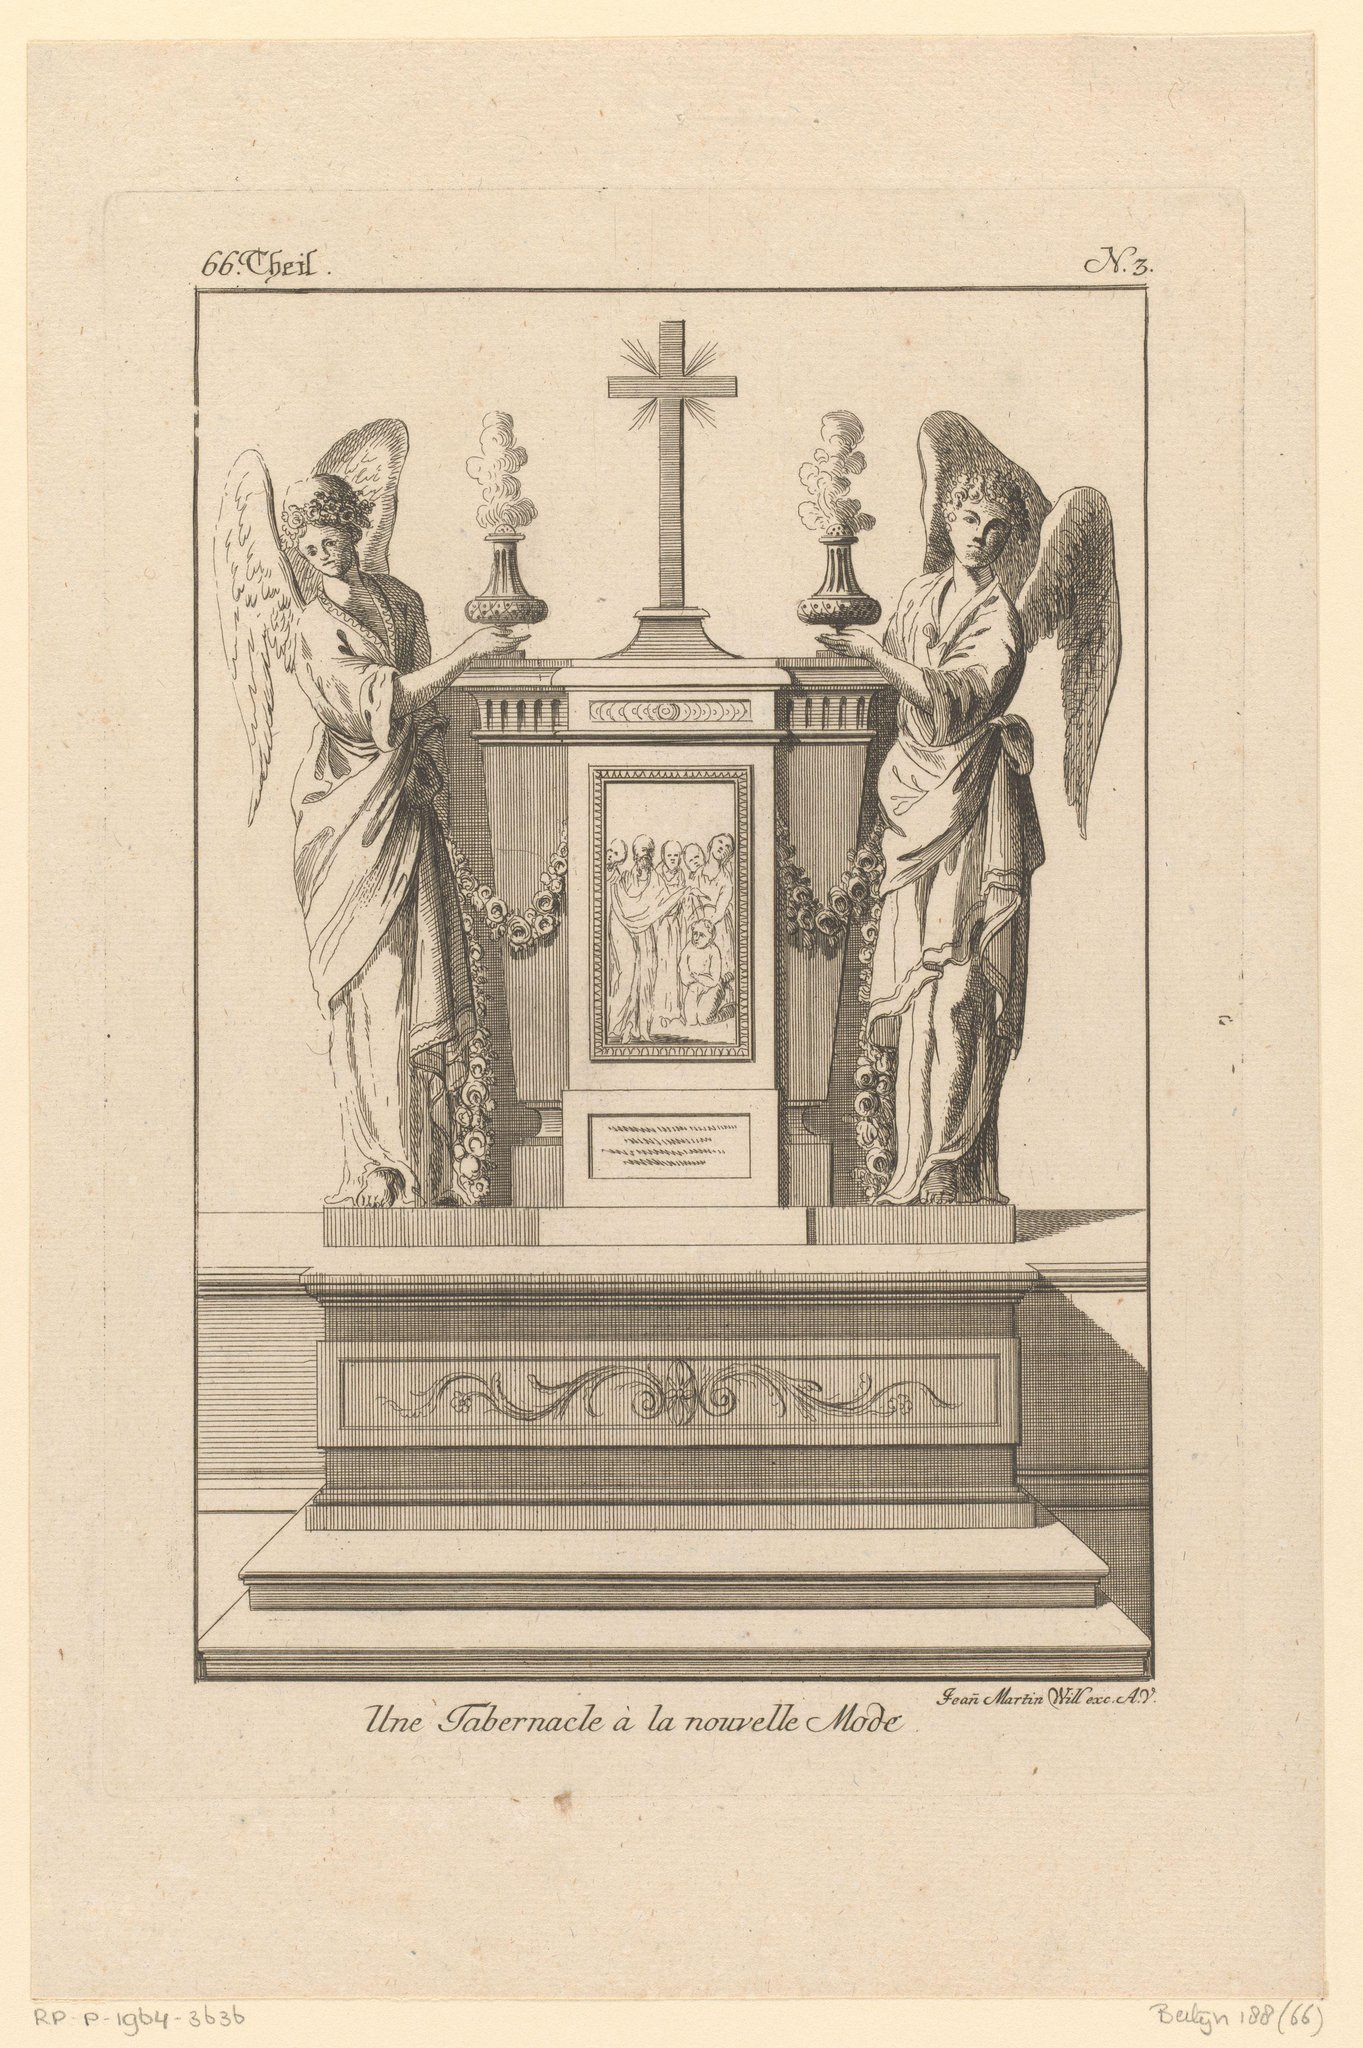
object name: print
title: 66. Theil. Une Tabernacle à la nouvelle Mode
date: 1737-1806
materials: paper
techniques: engraving, etching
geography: augsburg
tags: altarcross, crucifix, tabernacle ~ altar, angels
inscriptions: collector's mark: Lugt 2760, collector's mark: Lugt 2228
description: Een tabernakel met een kruis en guirlandes. Aan weerszijden staat een engel met een rookvat.